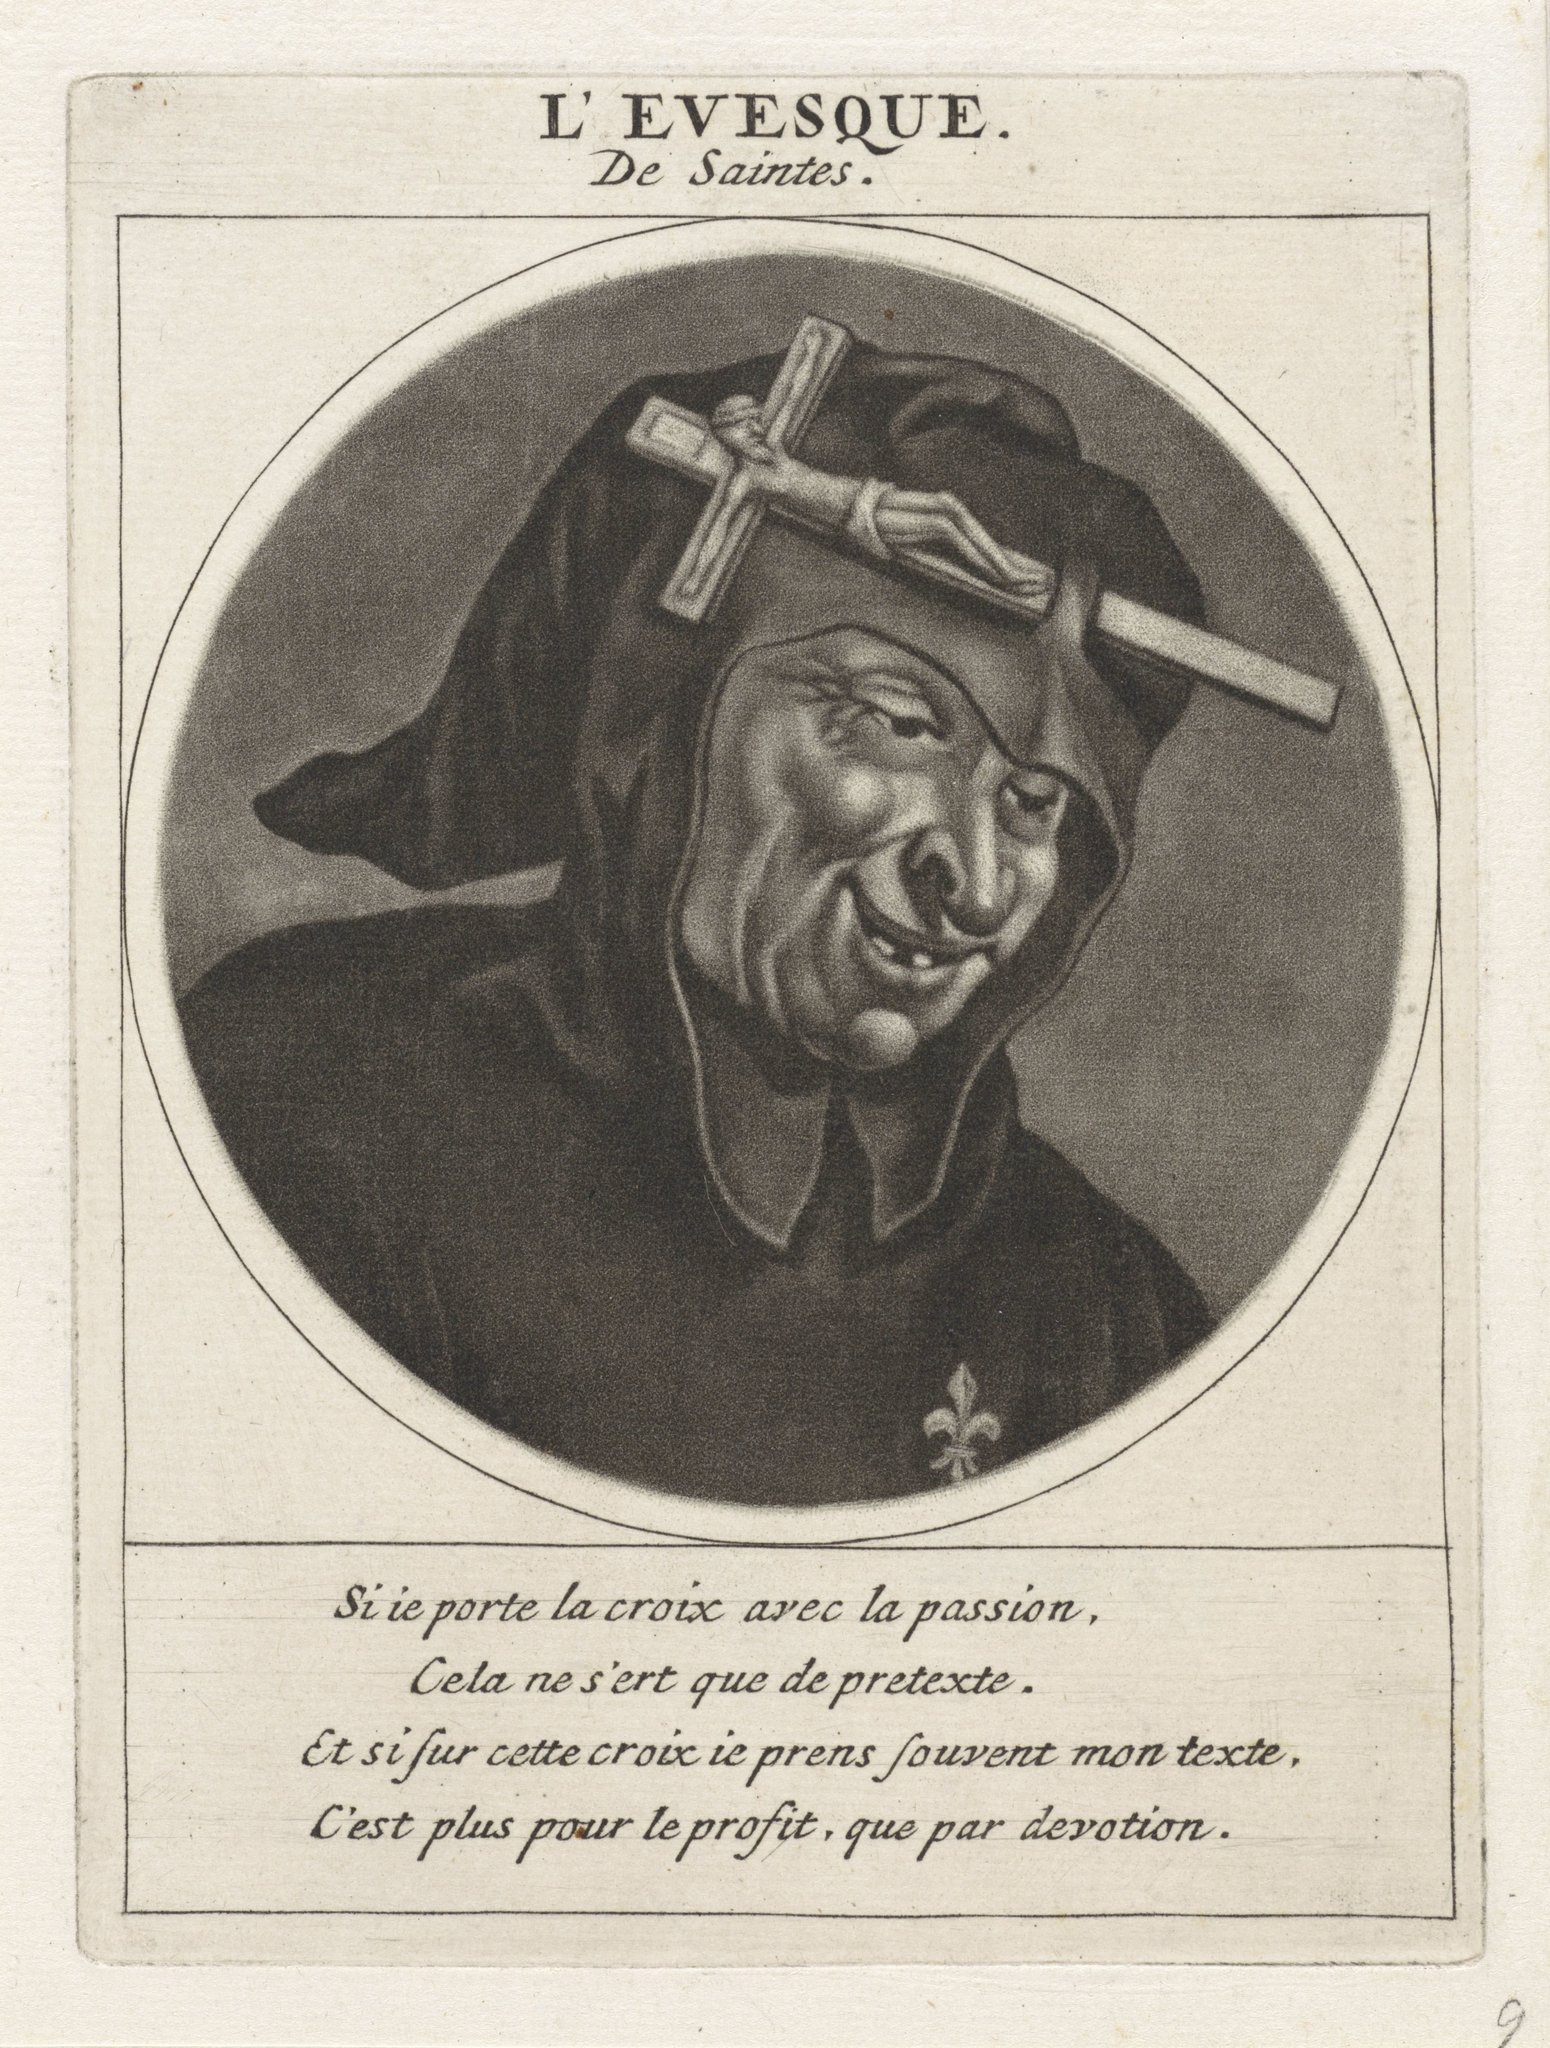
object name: print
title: Spotprenten op Lodewijk XIV en zijn gevolg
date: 1691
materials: paper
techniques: engraving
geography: paris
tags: fleur-de-lis ~ ornament, altarcross, crucifix, political caricatures and satires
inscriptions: collector's mark: Lugt 240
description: Titelpagina voor: Les Heros de la Ligue: ou la procession monacale, conduitte par Louis XIV, pour la conversion des Protestants de son royaume. Chez. Pere Peters en Louis le Grand: Parijs, 1691. (De uitgevers zijn fictief.)